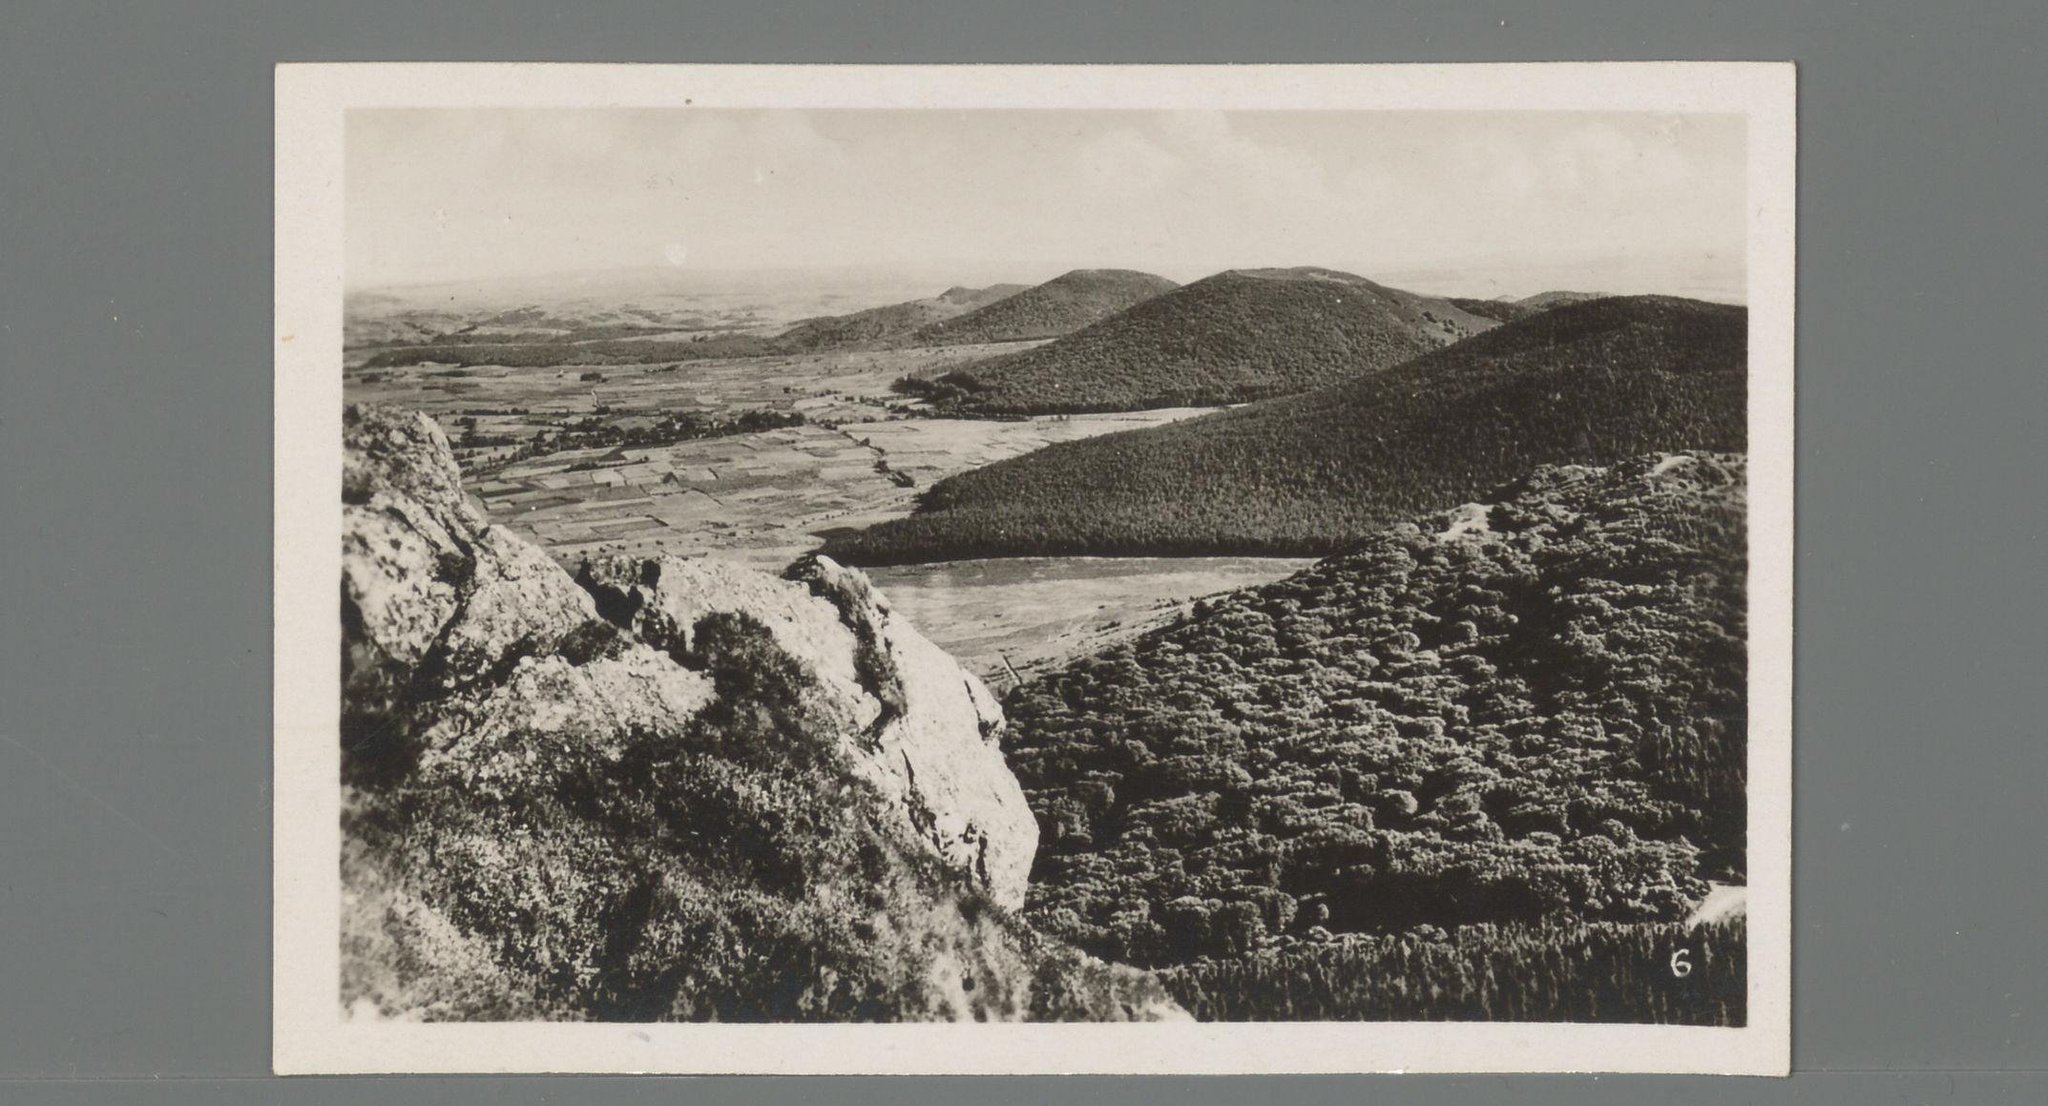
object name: photograph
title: L'Auvergne pittoresque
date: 1920-1932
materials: photographic support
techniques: photography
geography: auvergne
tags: (high) hill